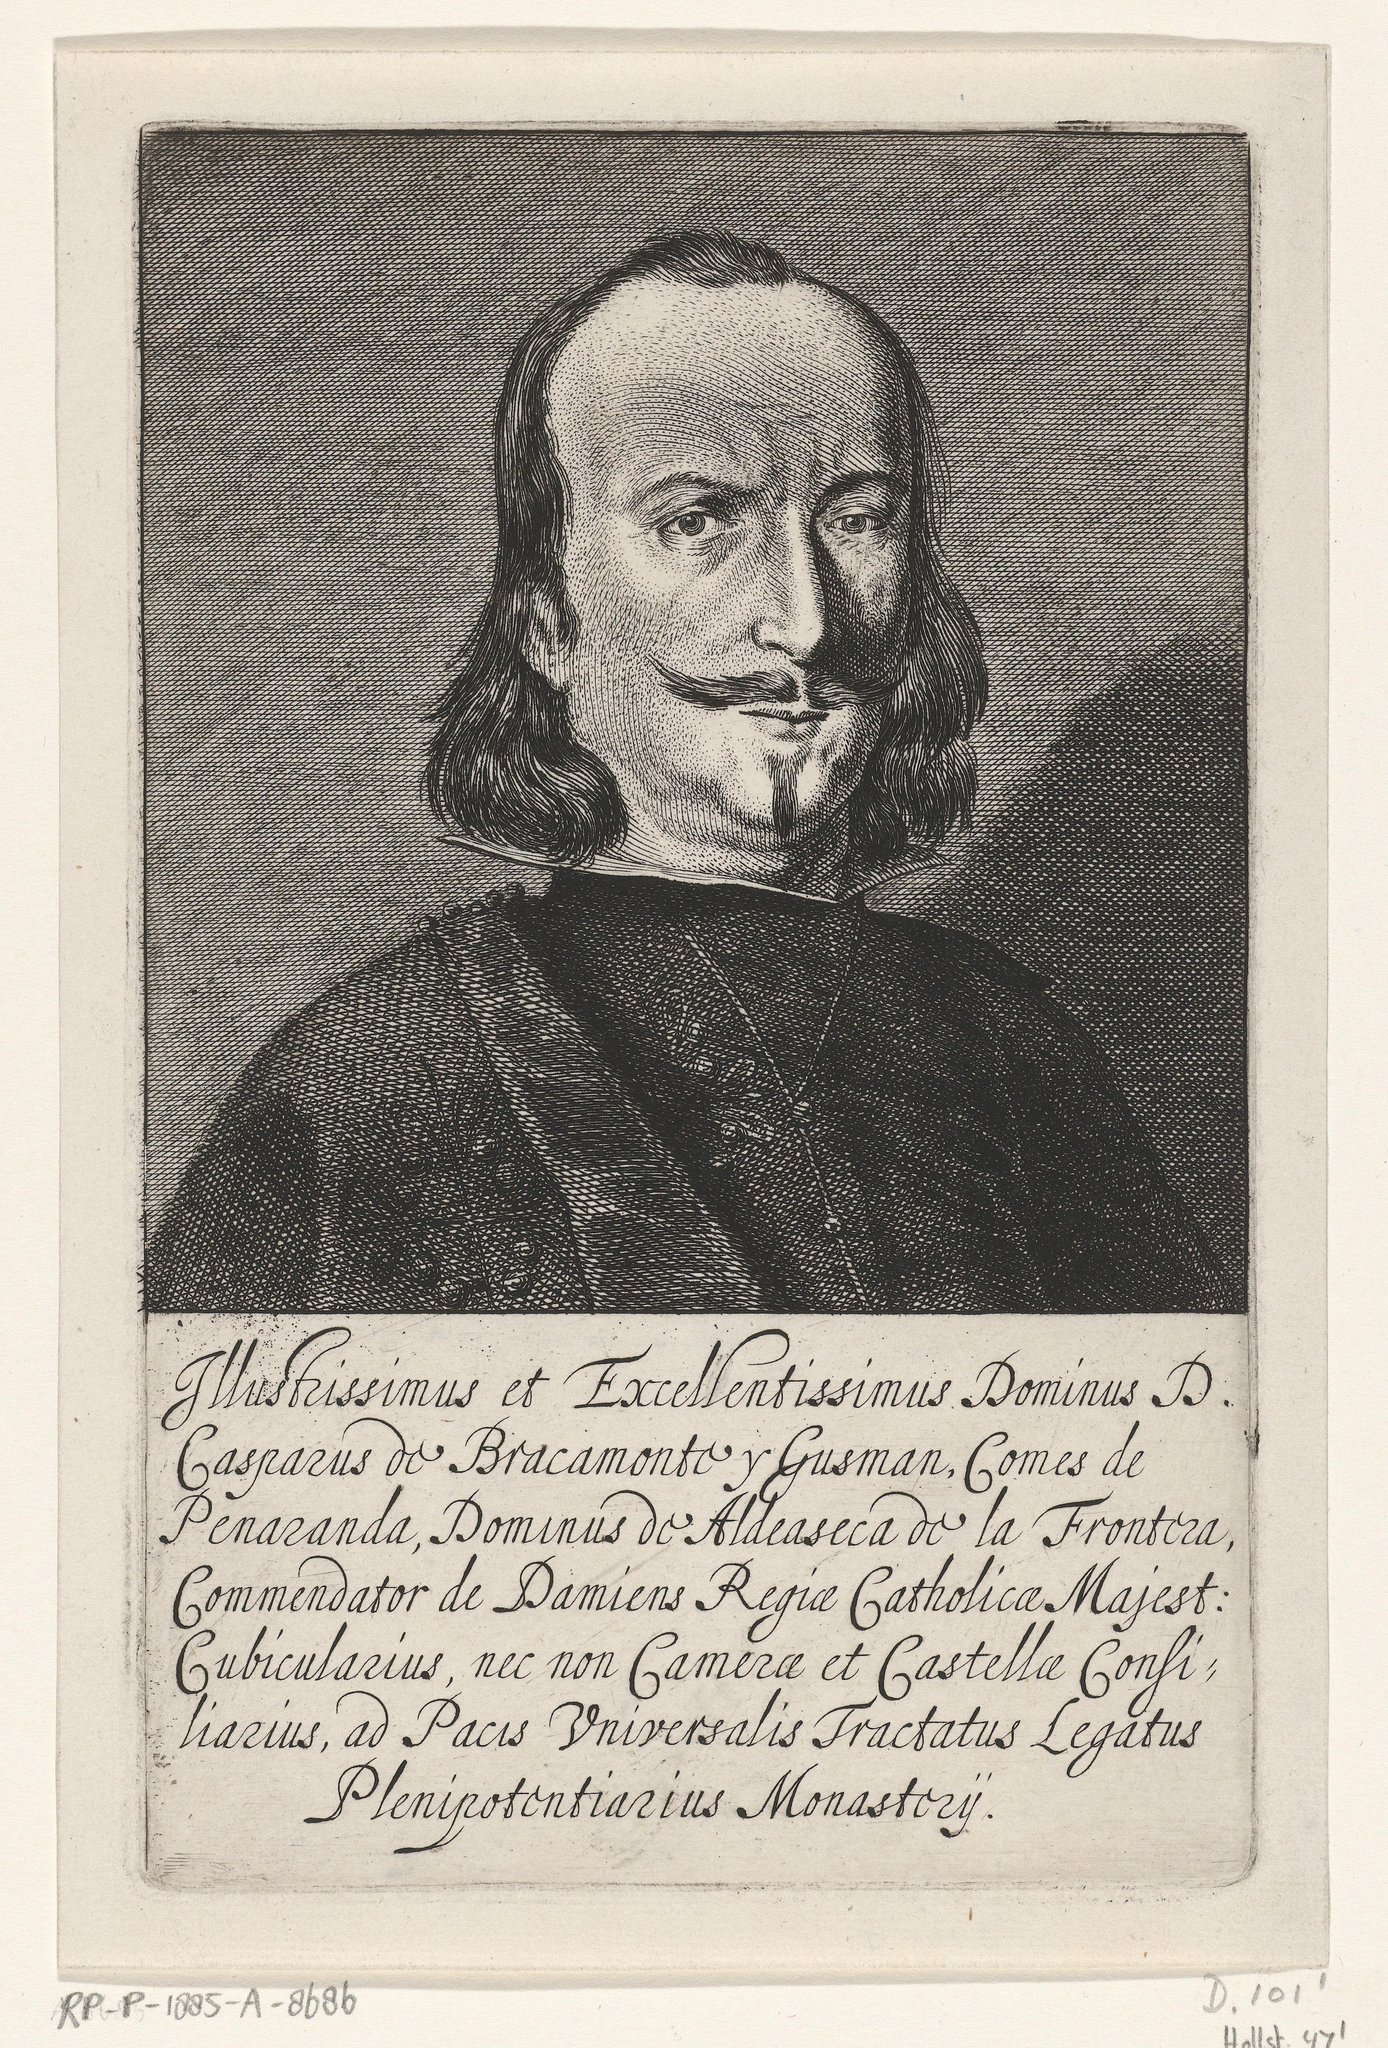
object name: print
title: Portret van graaf Gaspar de Bracamonte y Guzman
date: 1644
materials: paper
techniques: engraving, etching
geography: amsterdam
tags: gaspar de bracamonte y guzman (graaf van peñaranda)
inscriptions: collector's mark: Lugt 2228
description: Portret van Gaspar de Bracamonte y Guzman, graaf van Peñaranda, gekleed in een zwarte mantel met een opstaande kraag. Buste naar rechts. Onderaan in de marge een zevenregelige tekst in het Latijn.